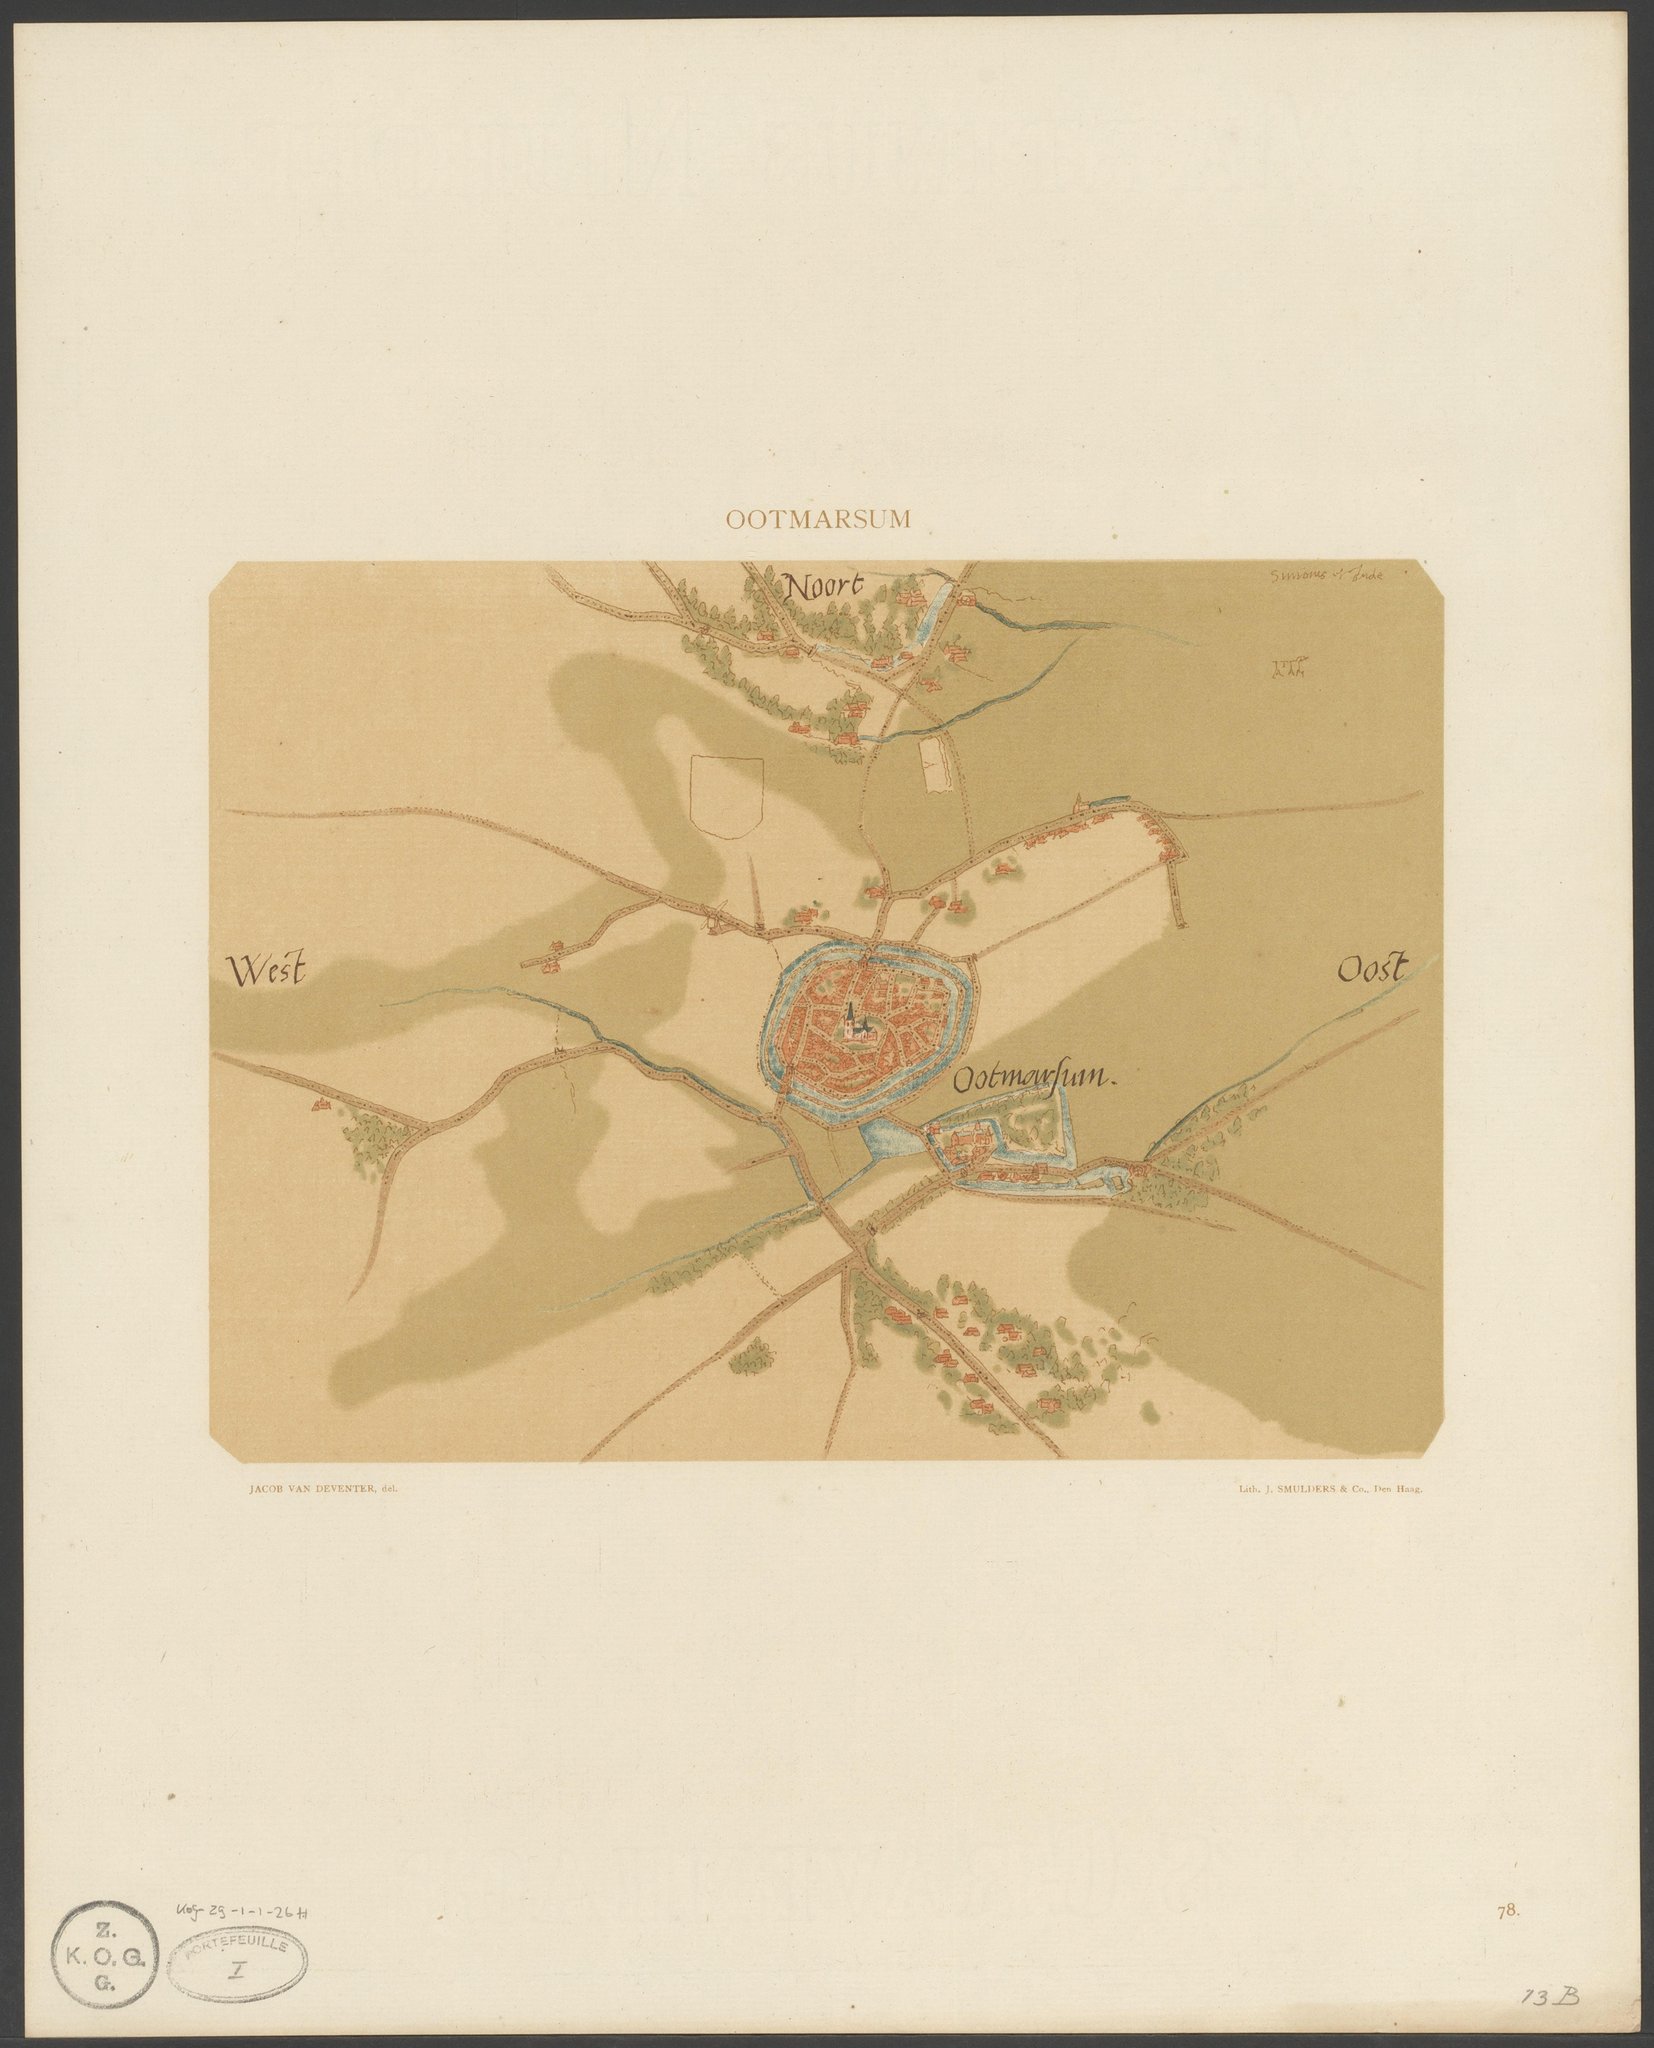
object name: area plan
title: Nederlandsche Steden in de 16e eeuw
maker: jacob van deventer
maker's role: draughtsman, print maker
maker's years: 1510-1575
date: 1916-1923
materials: paper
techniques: lithograph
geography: the hague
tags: maps of cities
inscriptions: collector's mark: Lugt 1641, collector's mark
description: Plattegrond van de plaats Ootmarsum. Genummerd rechtsonder: 78. Onderdeel van een serie 'Nederlandsche Steden in de 16e eeuw', reproducties naar de oorspronkelijke topografische tekeningen van Jacob van Deventer. Onderwerpsrubrieken binnen de Atlas Zeden en Gewoonten: topografie; stadsplattegronden.